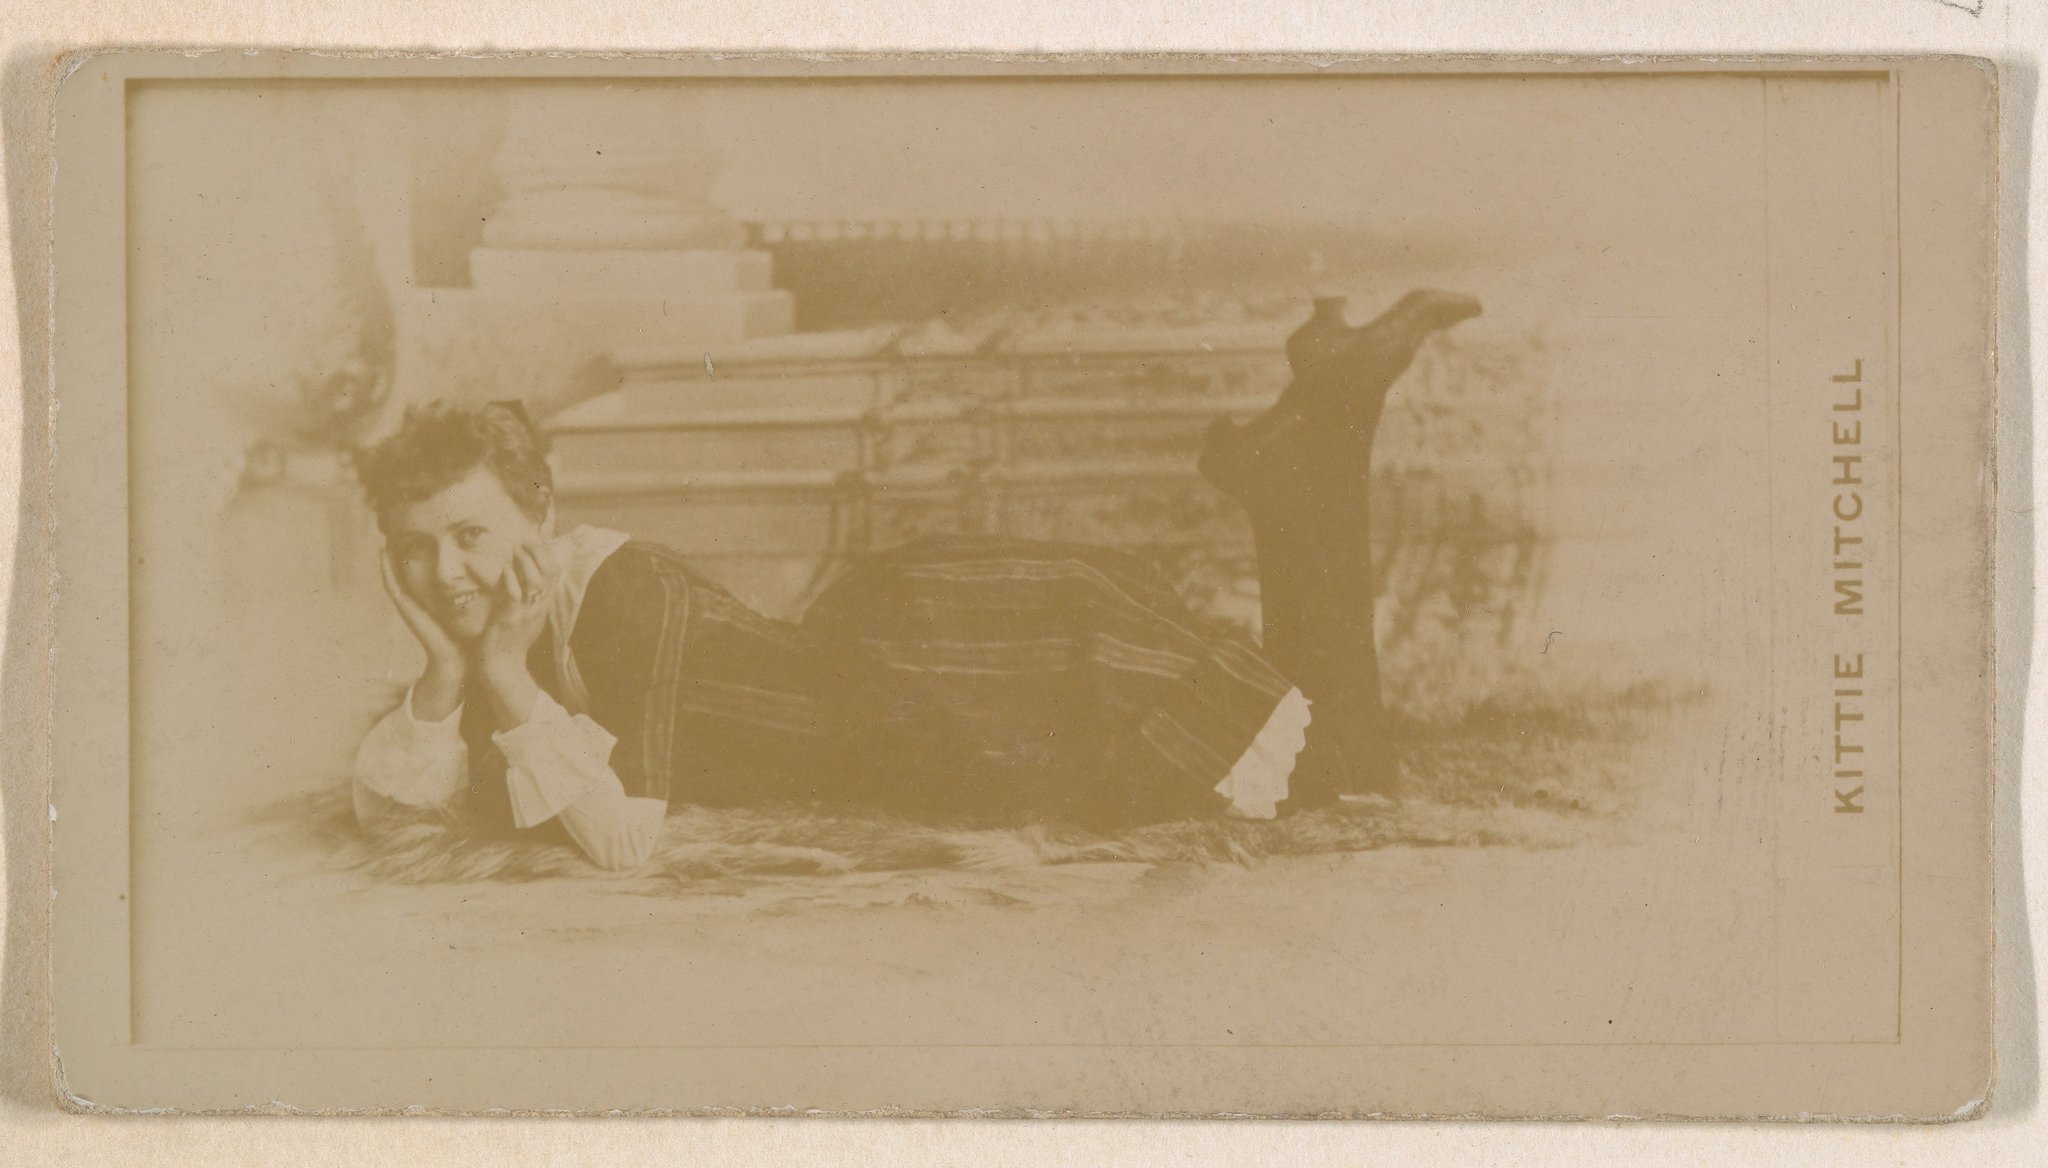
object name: photograph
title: Kittie Mitchell, from the Actresses series (N245) issued by Kinney Brothers to promote Sweet Caporal Cigarettes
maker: kinney brothers tobacco company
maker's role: publisher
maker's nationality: american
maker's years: 1869-2011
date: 1890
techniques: albumen silver print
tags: portraits,women,actresses